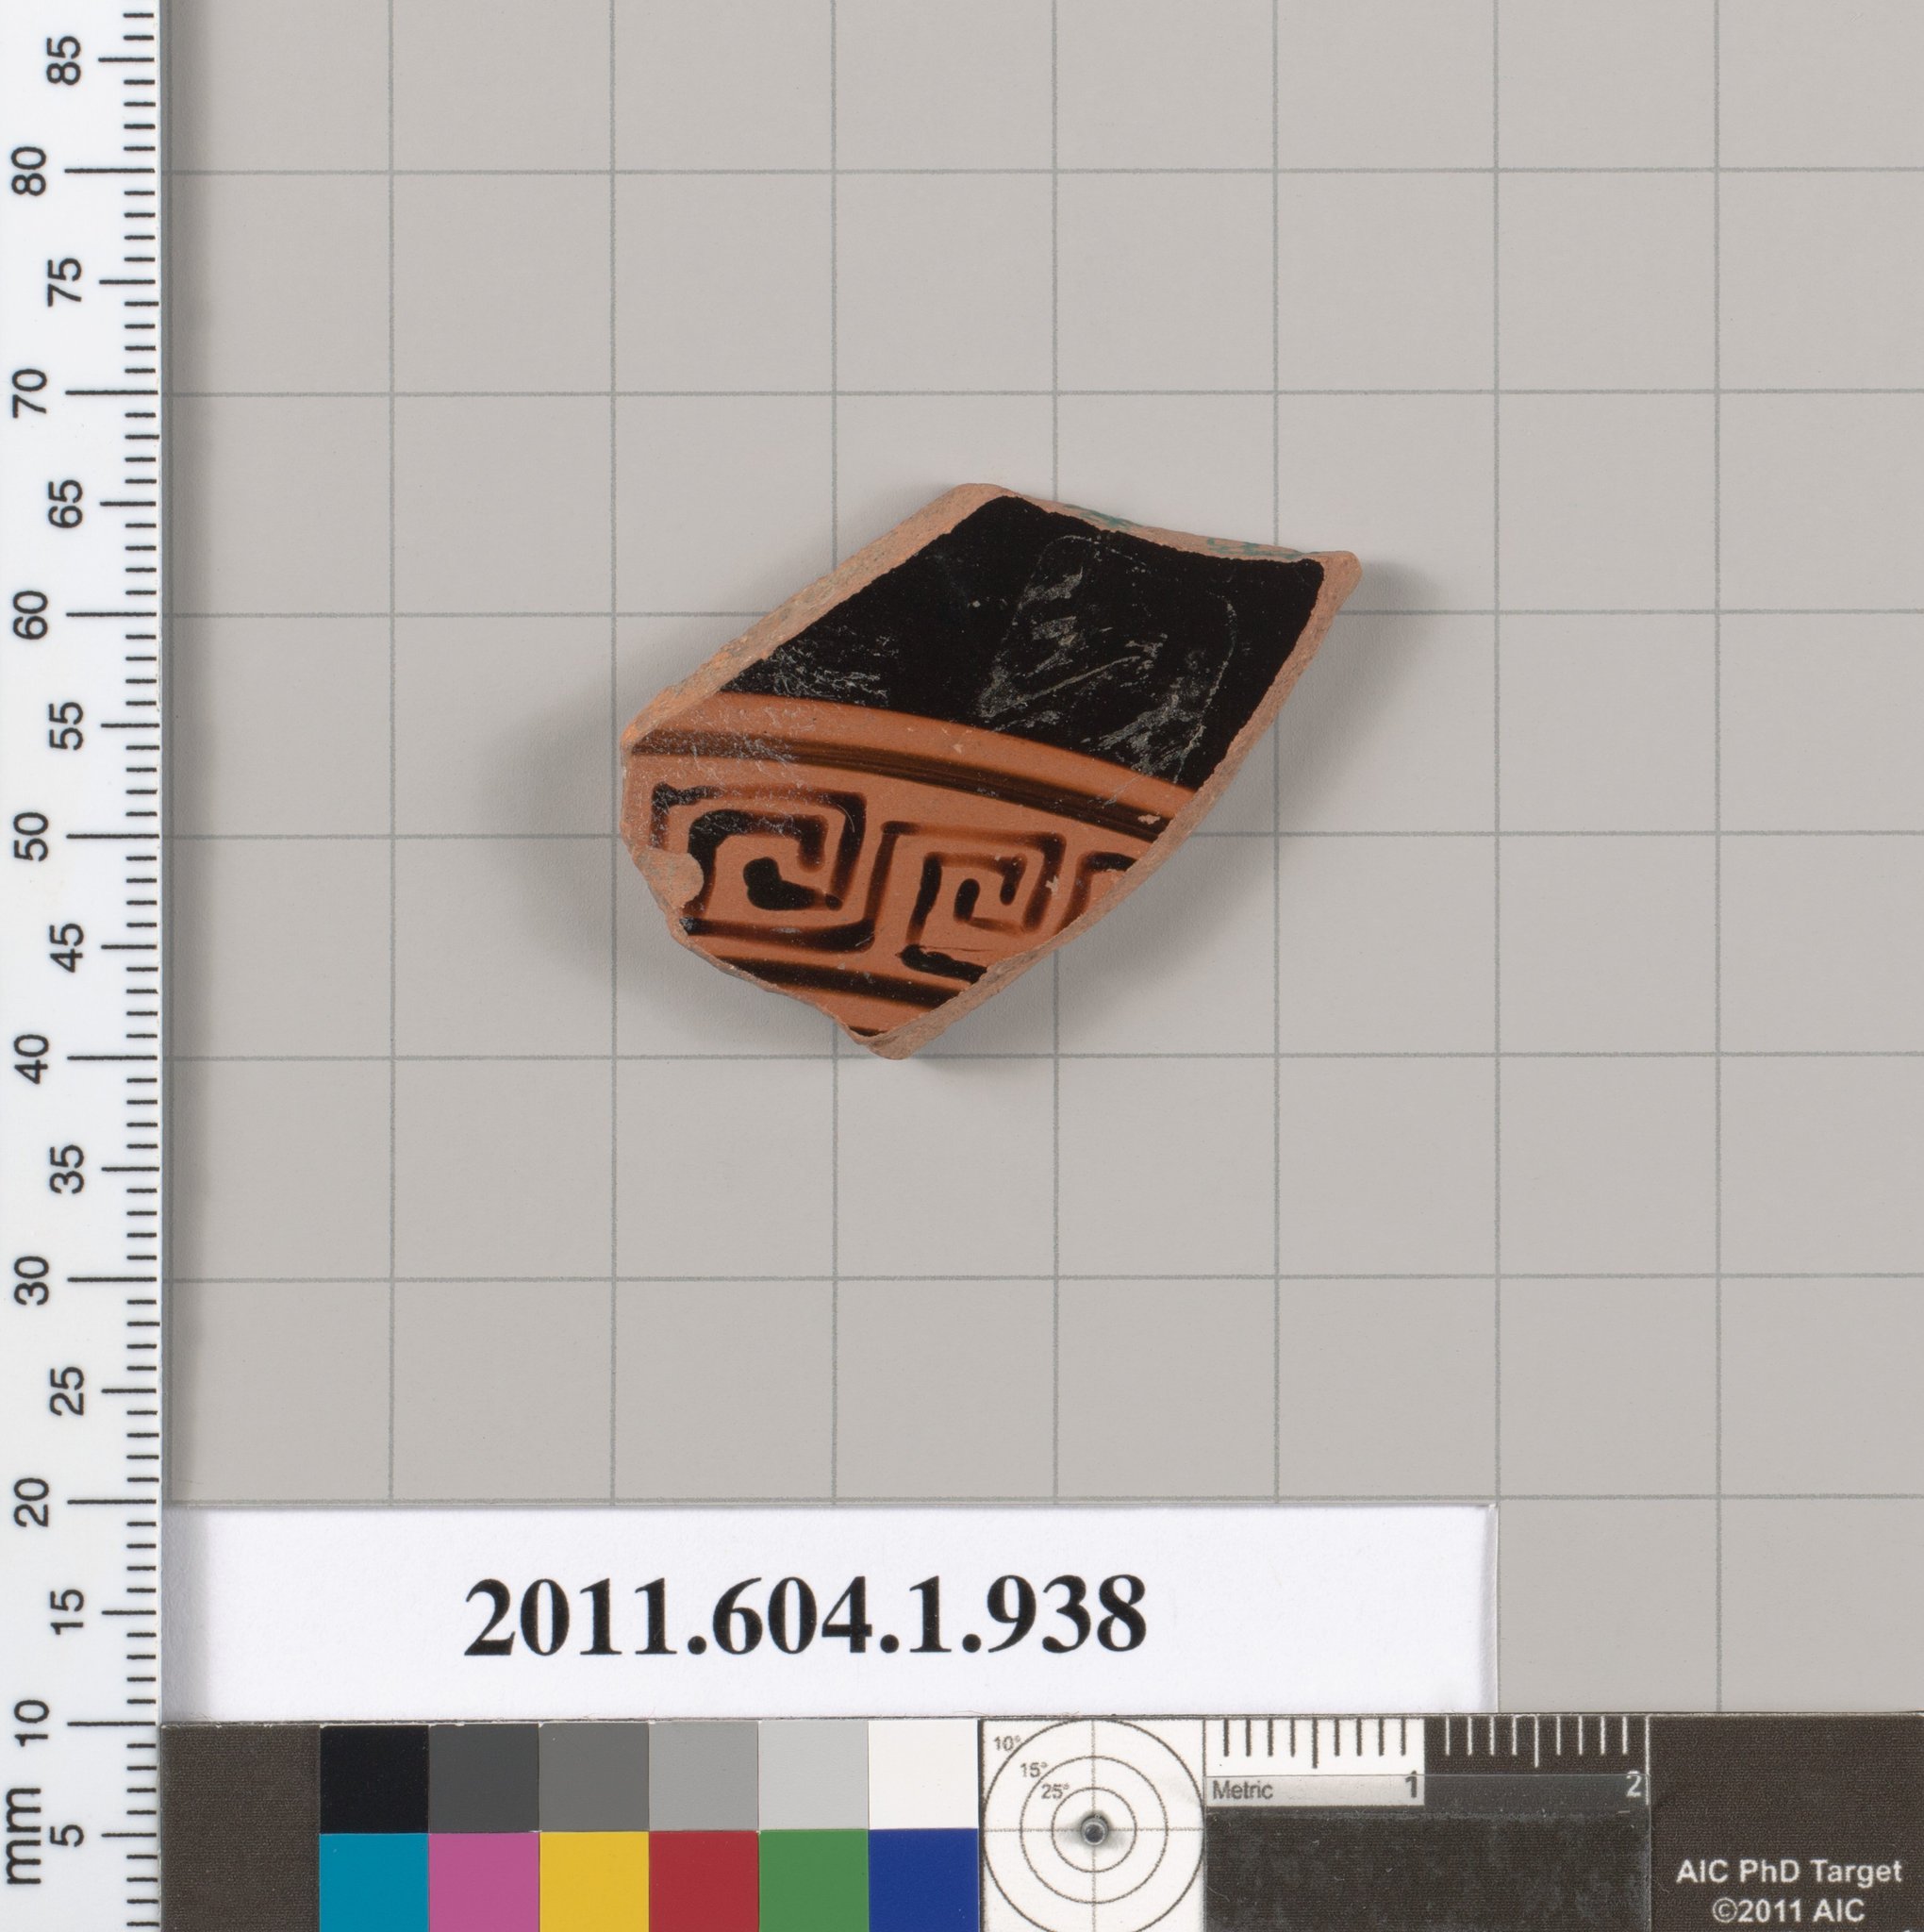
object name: kylix fragment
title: Terracotta fragment of a kylix (drinking cup)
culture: greek, attic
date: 490-480 BCE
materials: terracotta